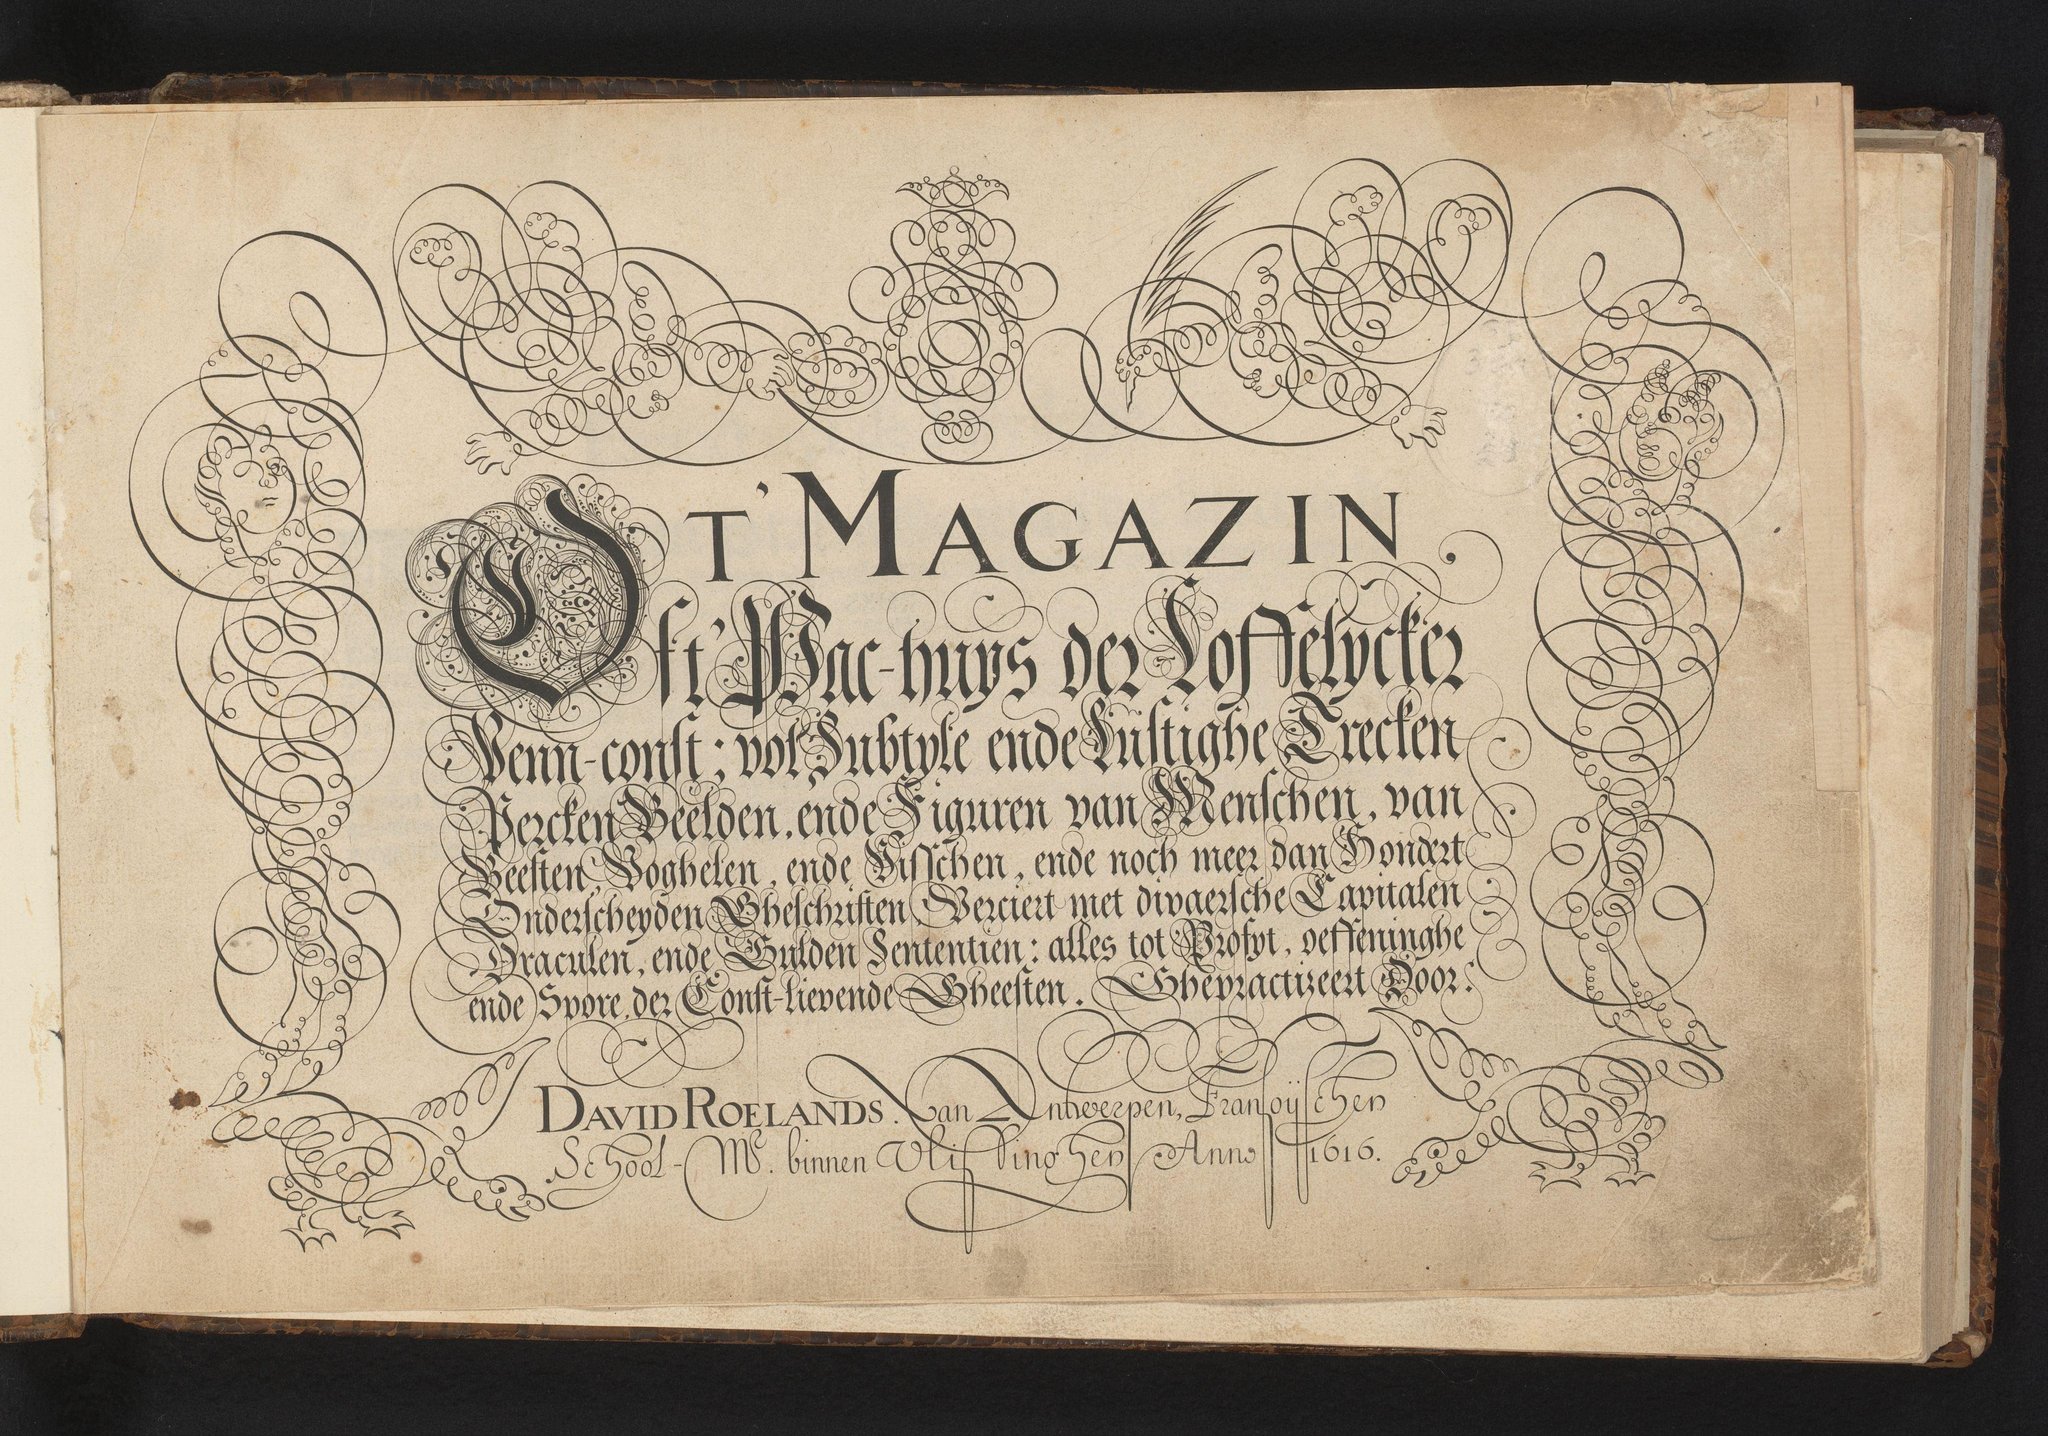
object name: titelprent, frontispice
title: Kalligrafische titelprent en putti, vogels en saters in krulwerk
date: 1616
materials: paper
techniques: engraving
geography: flushing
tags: calligraphy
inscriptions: collector's mark: Lugt 2166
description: Een kalligrafische titel met geornamenteerde initiaal O, omlijst door krulwerk. Bovenaan een vaas geflankeerd door twee putti. De putti rechts heeft een schrijfveer vast. Daarbij twee saters en twee vogels in krulwerk. De prent maakt deel van een album.